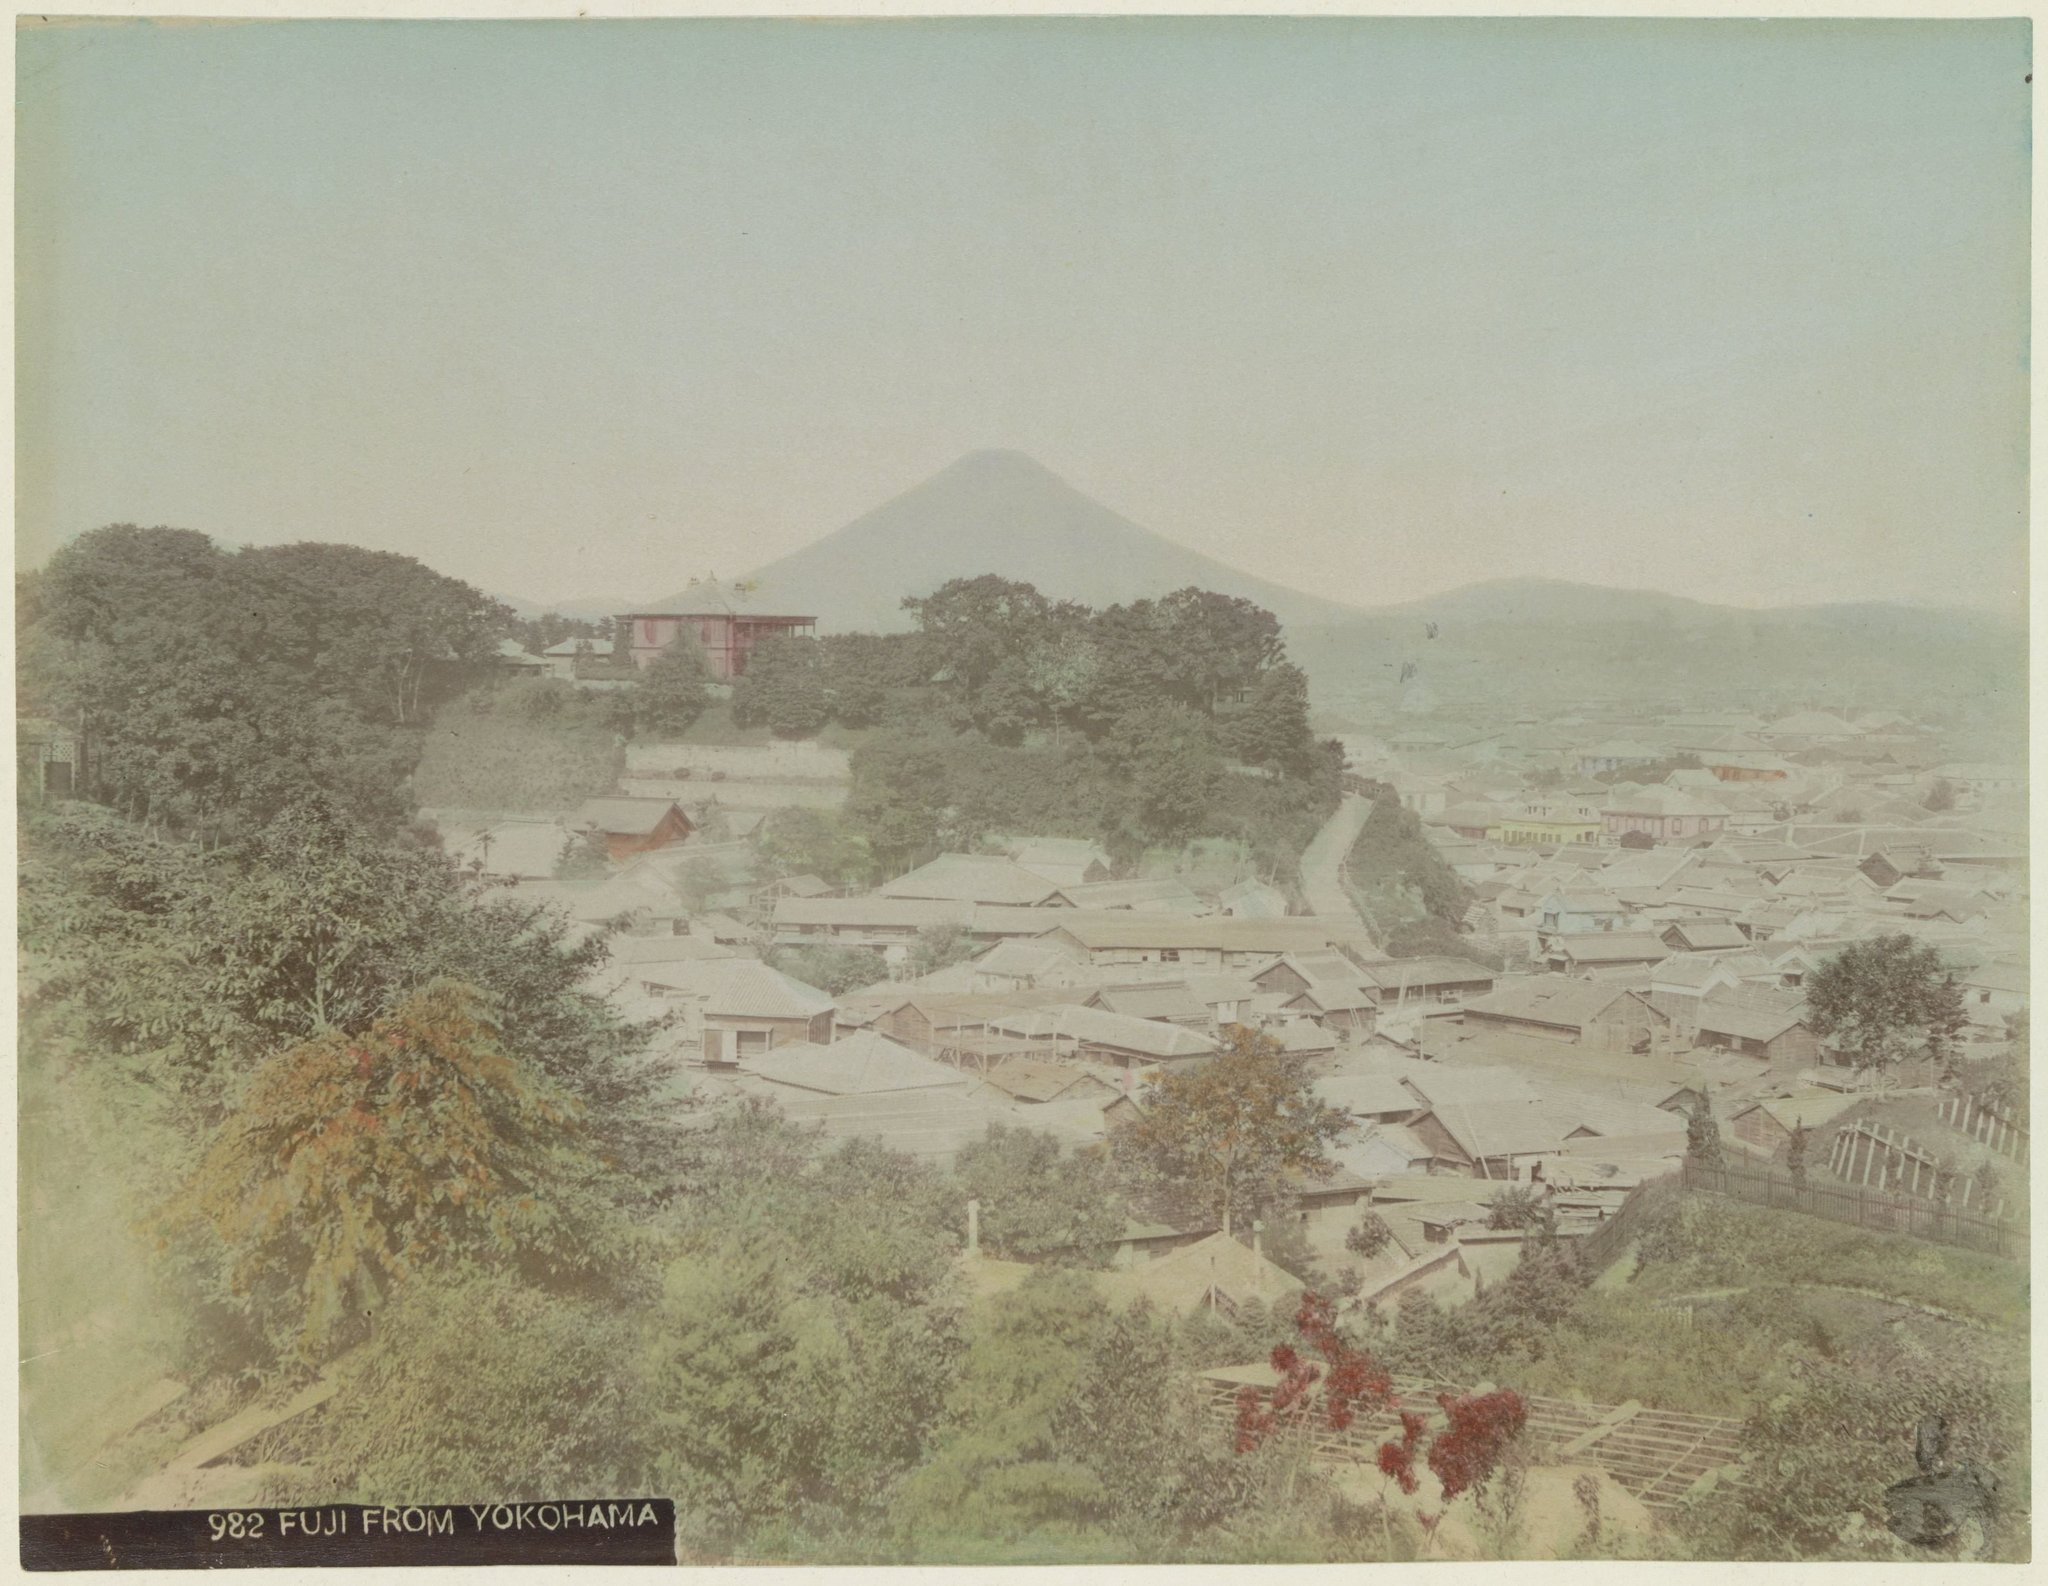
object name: photograph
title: Gezicht op Yokohama met op de achtergrond de berg Fuji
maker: Anonymous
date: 1870-1900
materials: cardboard, paper, photographic support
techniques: albumen print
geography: yokohama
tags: prospect of village, silhouette of village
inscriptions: negative number: ‘982’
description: Onderdeel van Reisalbum met foto's van bezienswaardigheden in Japan.